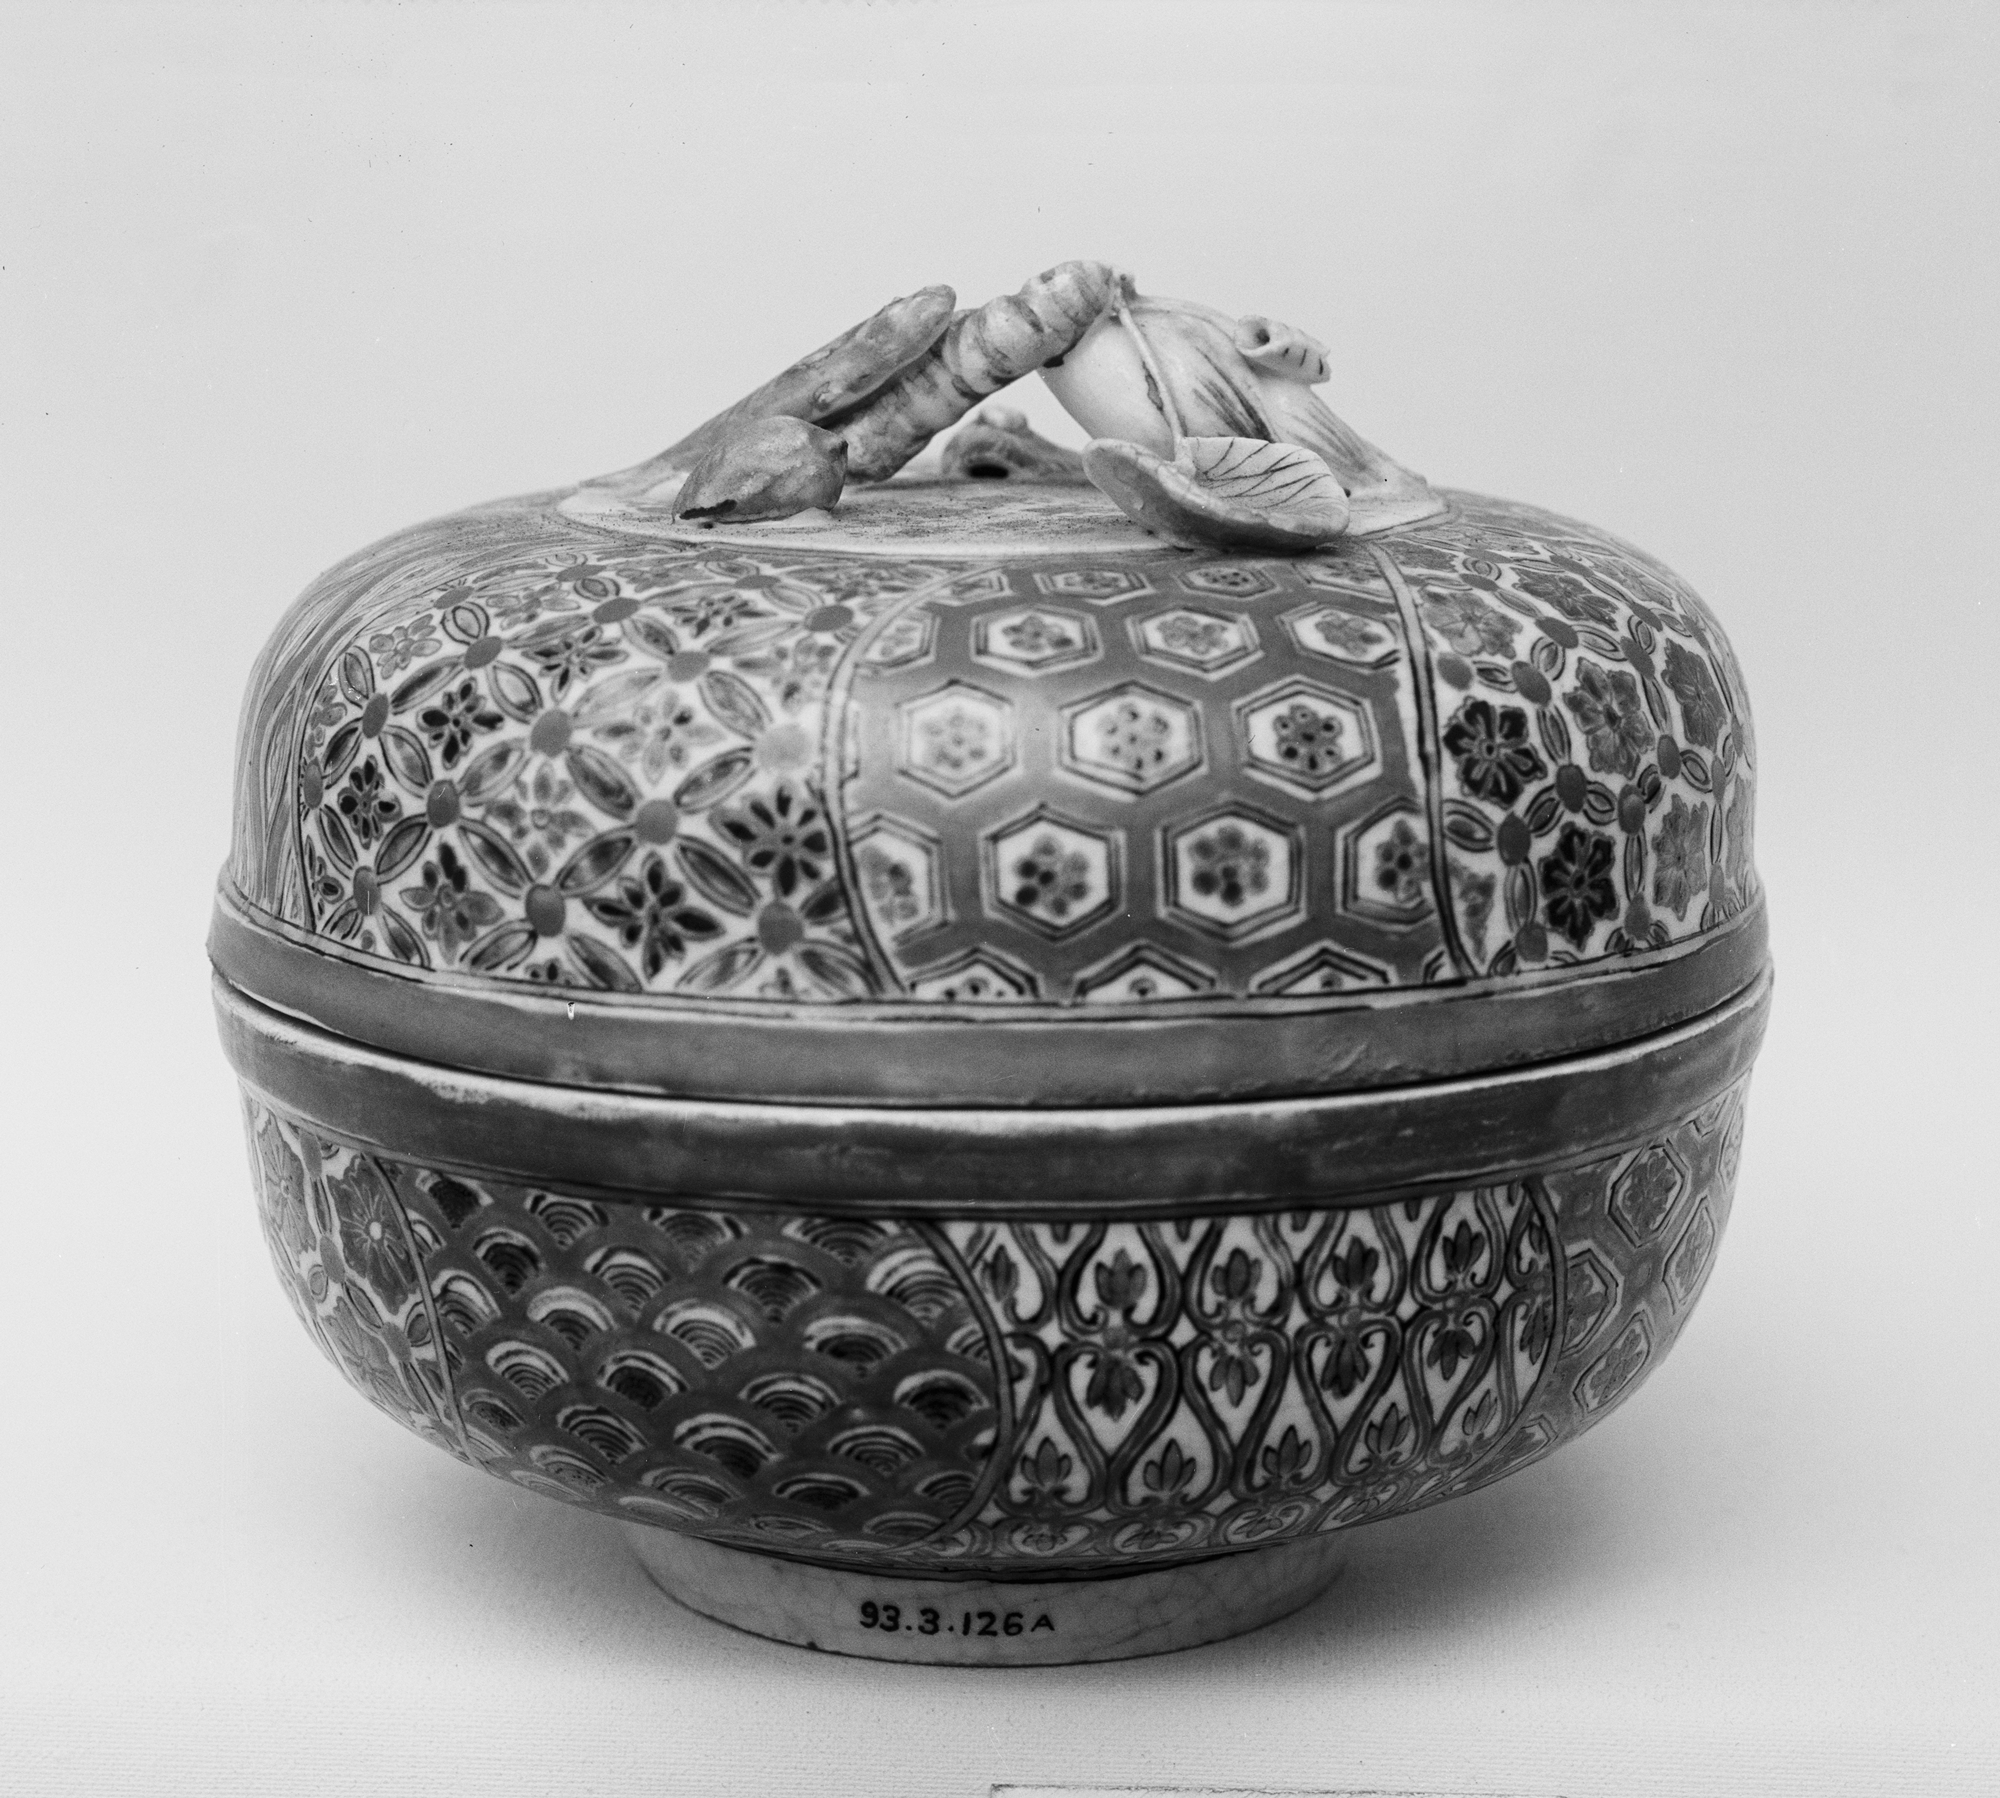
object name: box with cover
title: Box and Cover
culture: japanese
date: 1801-1900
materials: clay, enamel, glaze, gold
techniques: polychrome